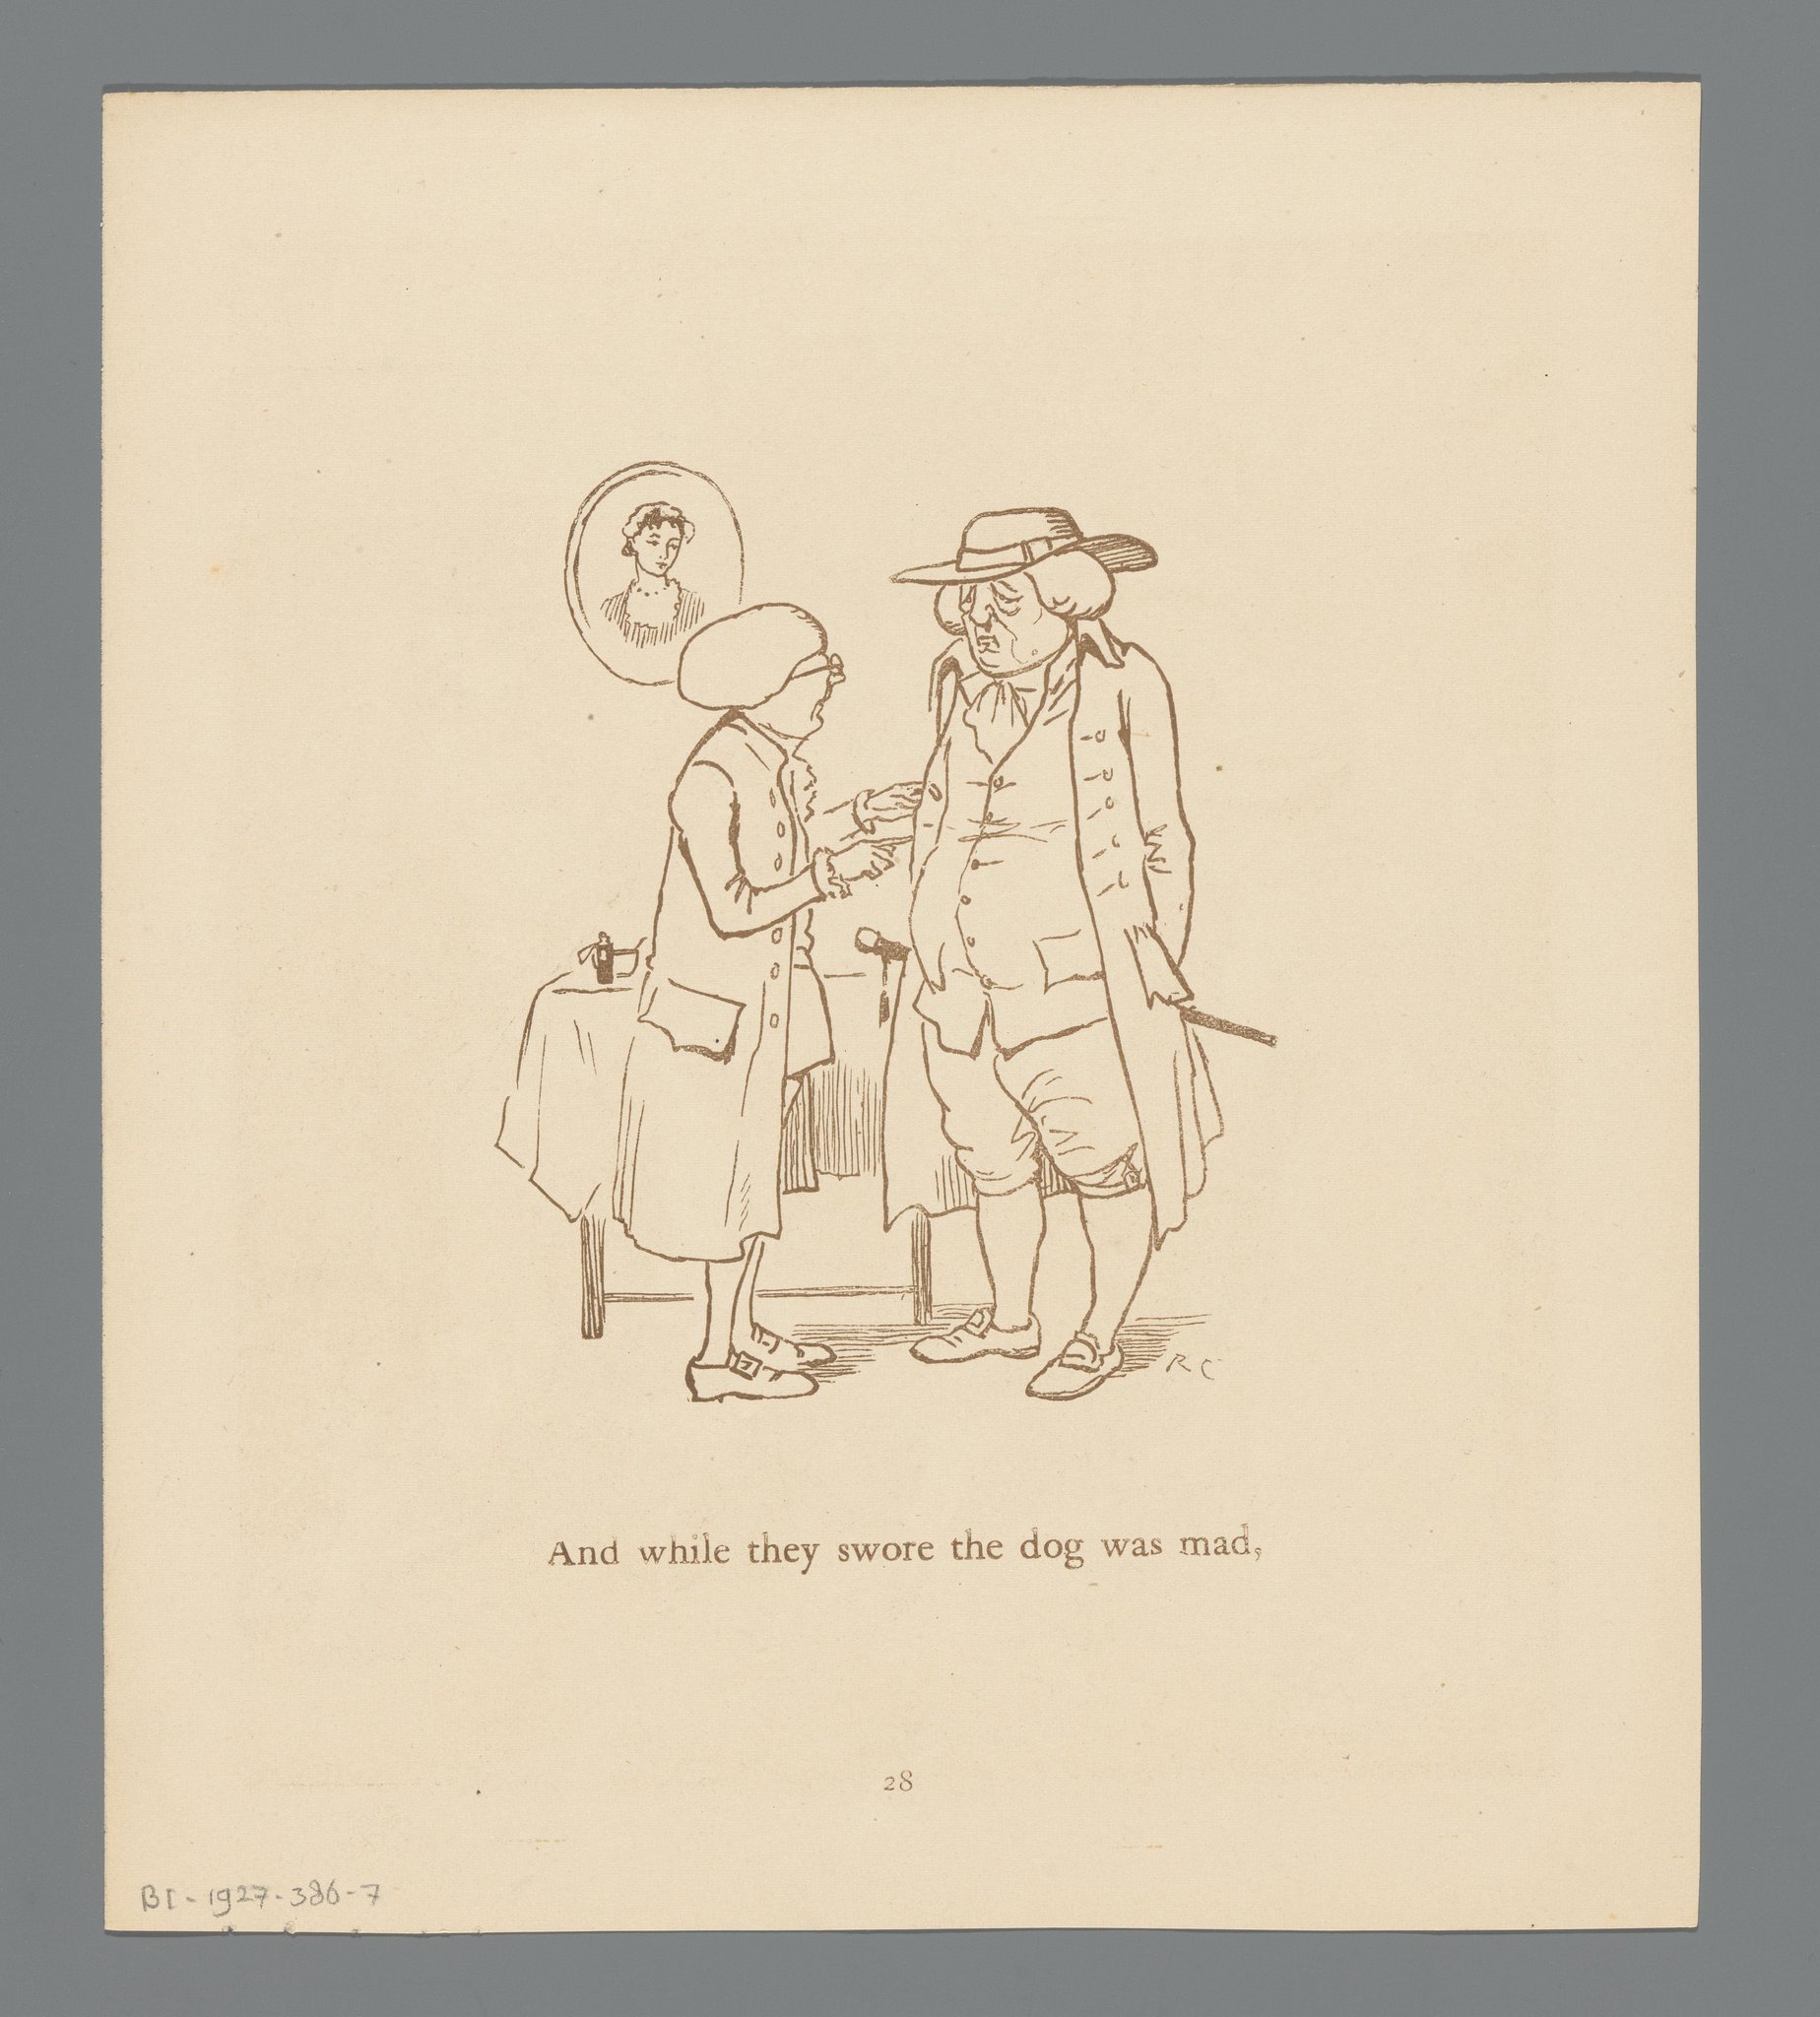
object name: book illustration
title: Twee mannen bij een tafel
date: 1879-1927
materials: paper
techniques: letterpress printing, engraving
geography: london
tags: adult man (+ two persons), table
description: Prent uit: Goldsmith, Oliver. Elegy on a mad dog. Londen: George Routledge & Sons, 1879. Of uit een later gepubliceerde uitgave waarin vier verhalen (waaronder 'Elegy on a mad dog') zijn gebundeld.